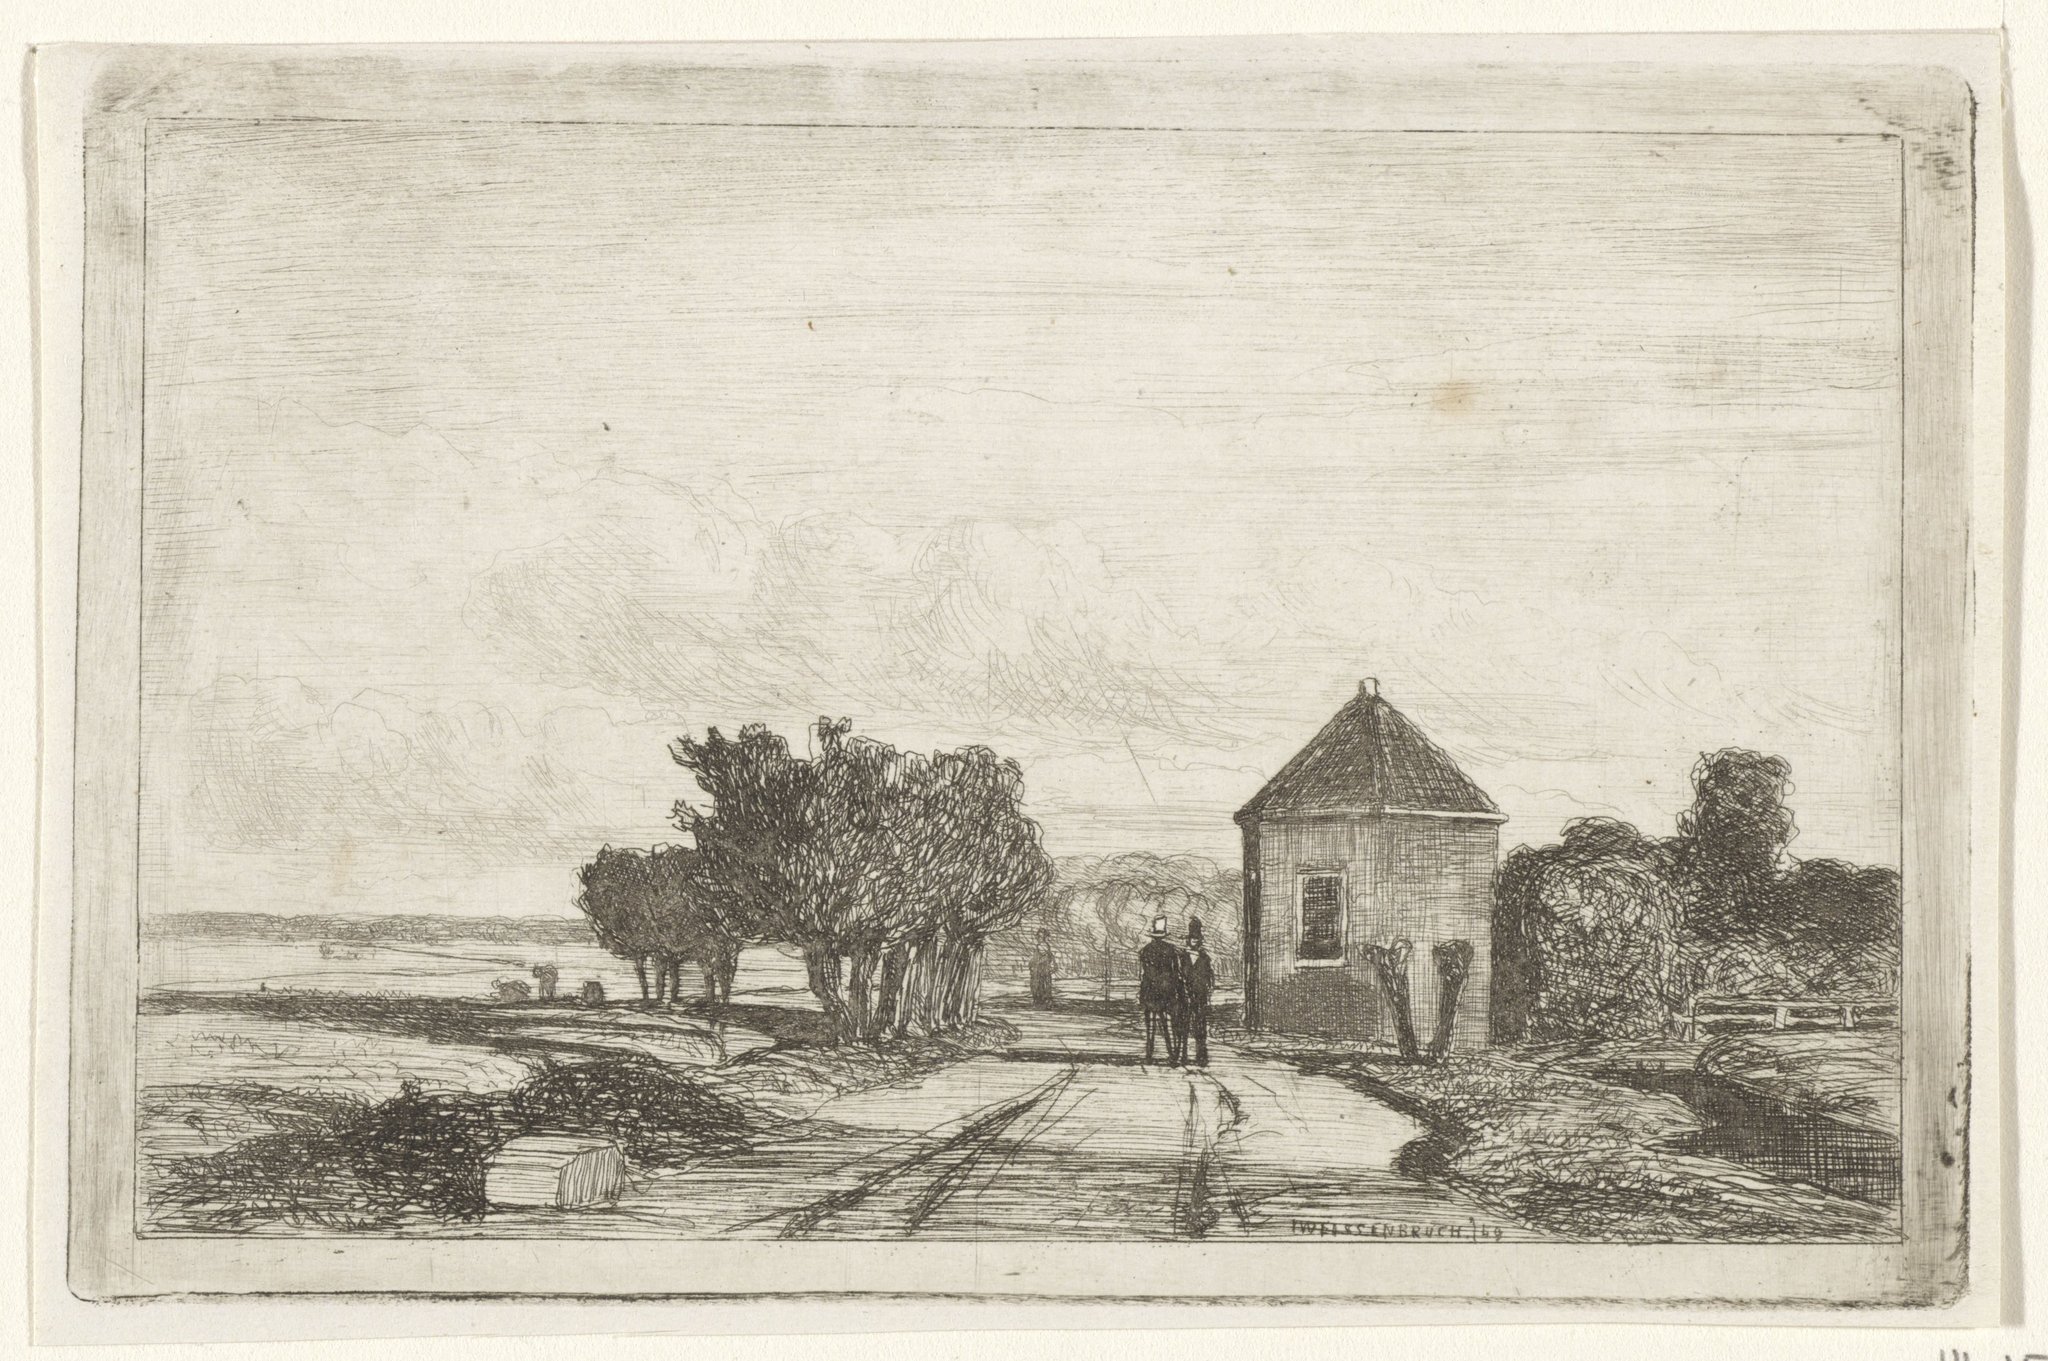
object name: print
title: Gezicht op de Schenkweg met de Koepel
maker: jan weissenbruch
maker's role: painter, print maker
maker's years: 1822-1880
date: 1849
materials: paper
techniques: etching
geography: the hague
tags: trees, landscapes, adult man, road, path, workshop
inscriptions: date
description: Langs de Schenkweg te Den Haag staan enkele bomen. Rechts staat een gebouw dat door de kunstenaar Johannes van der Drift als atelier werd gebruikt. Op de weg staan enkele figuren, onder wie mogelijk leden van de Haagsche Etsclub.